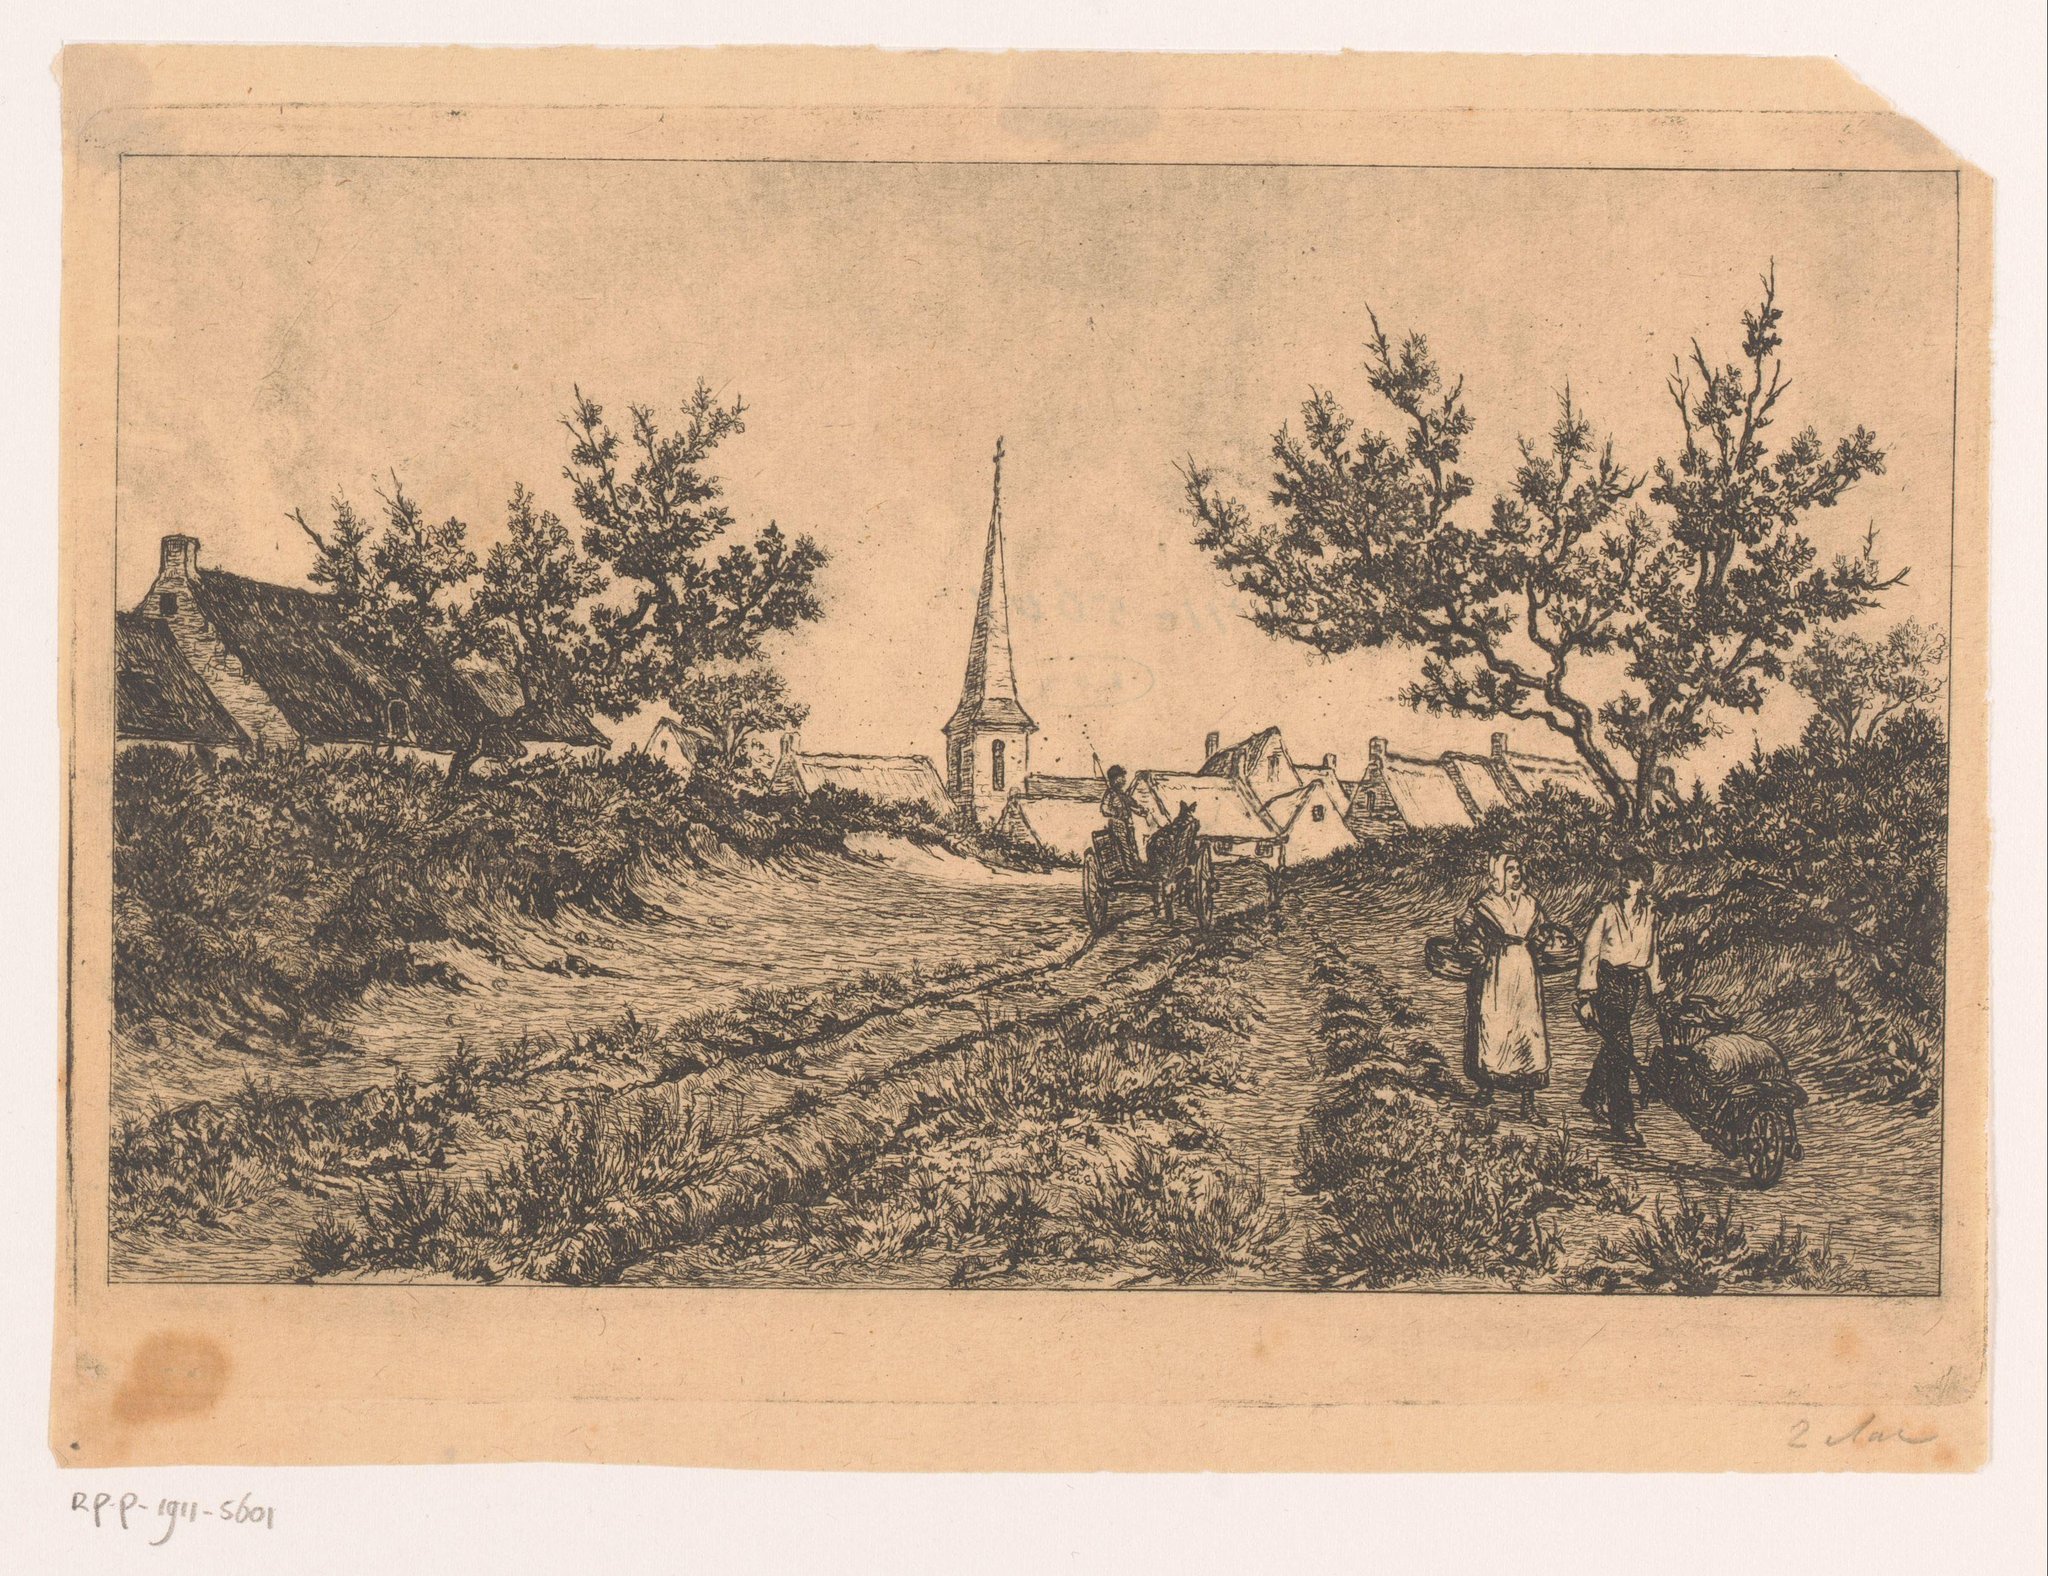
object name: print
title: Dorpsgezicht met landweg in de Kempen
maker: frans van kuyck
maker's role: painter, print maker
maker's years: 1852-1915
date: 1862-1911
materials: paper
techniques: etching, intaglio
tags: prospect of village, silhouette of village, four-wheeled vehicle drawn by one animal, road, path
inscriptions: collector's mark: Lugt 2228